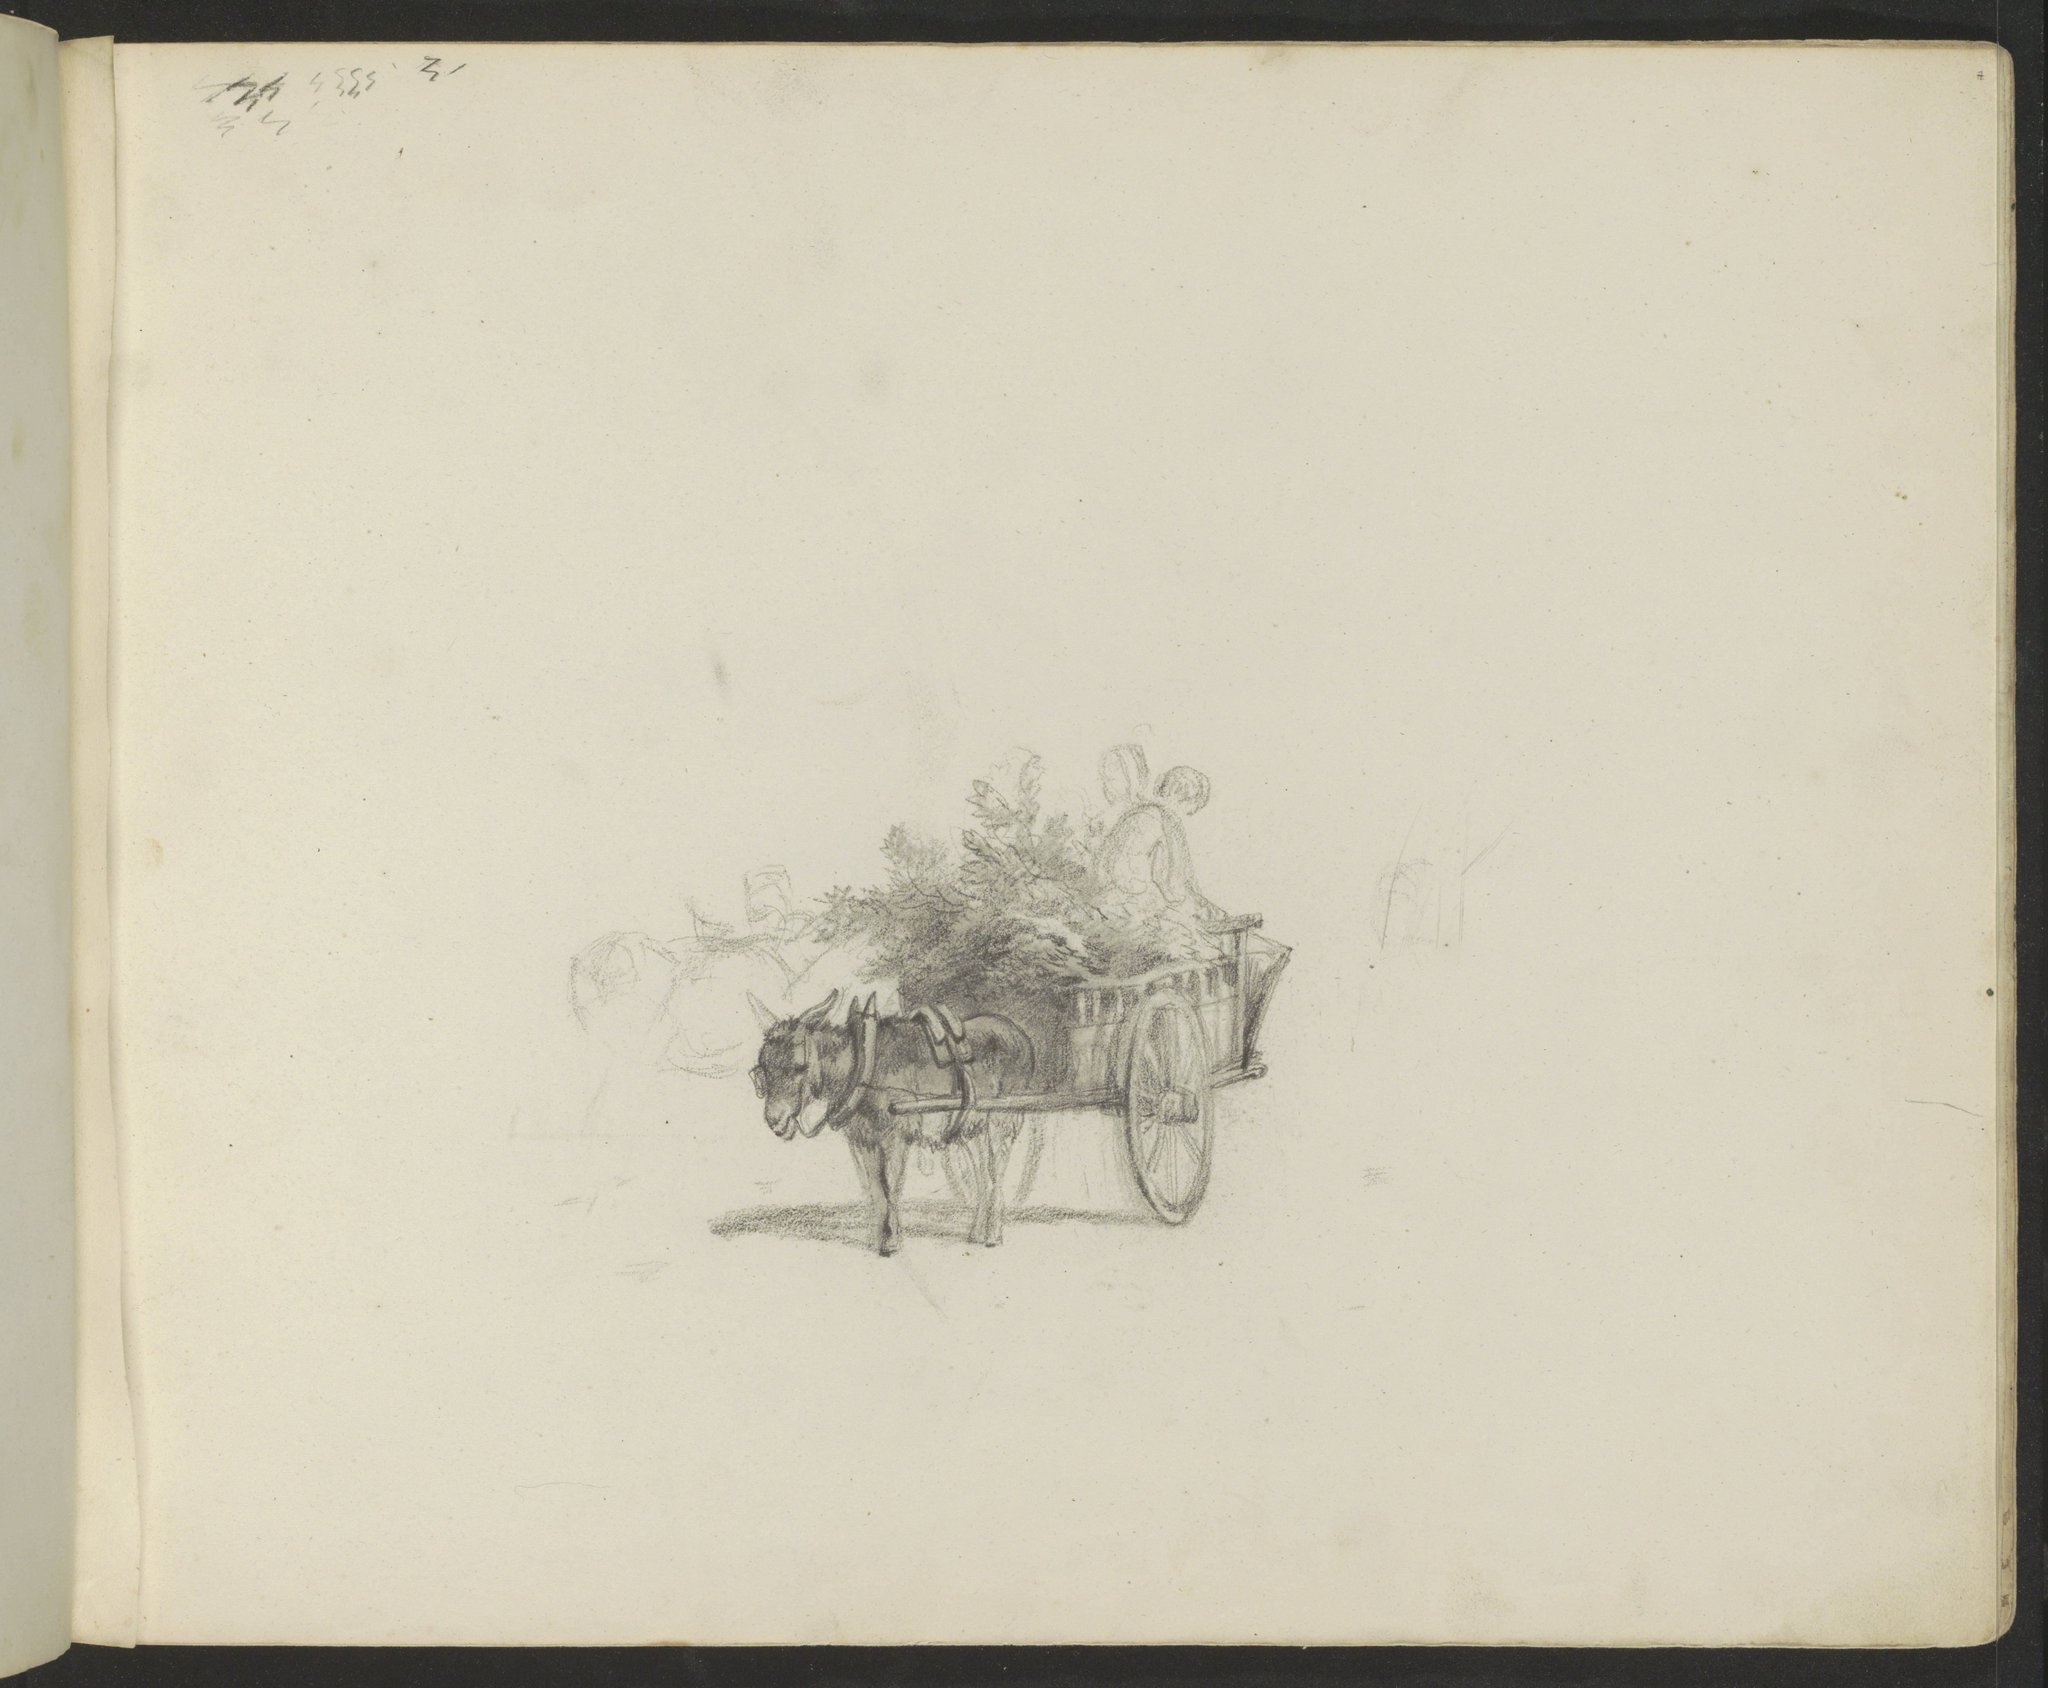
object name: sketchbook leaf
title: Twee figuren en takken op een ezelkar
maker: Anonymous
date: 1800-1899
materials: chalk, paper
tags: animal traction, animal-drawn vehicle (carriage etc.), mule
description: Blad 7 recto uit een schetsboek met 13 bladen.